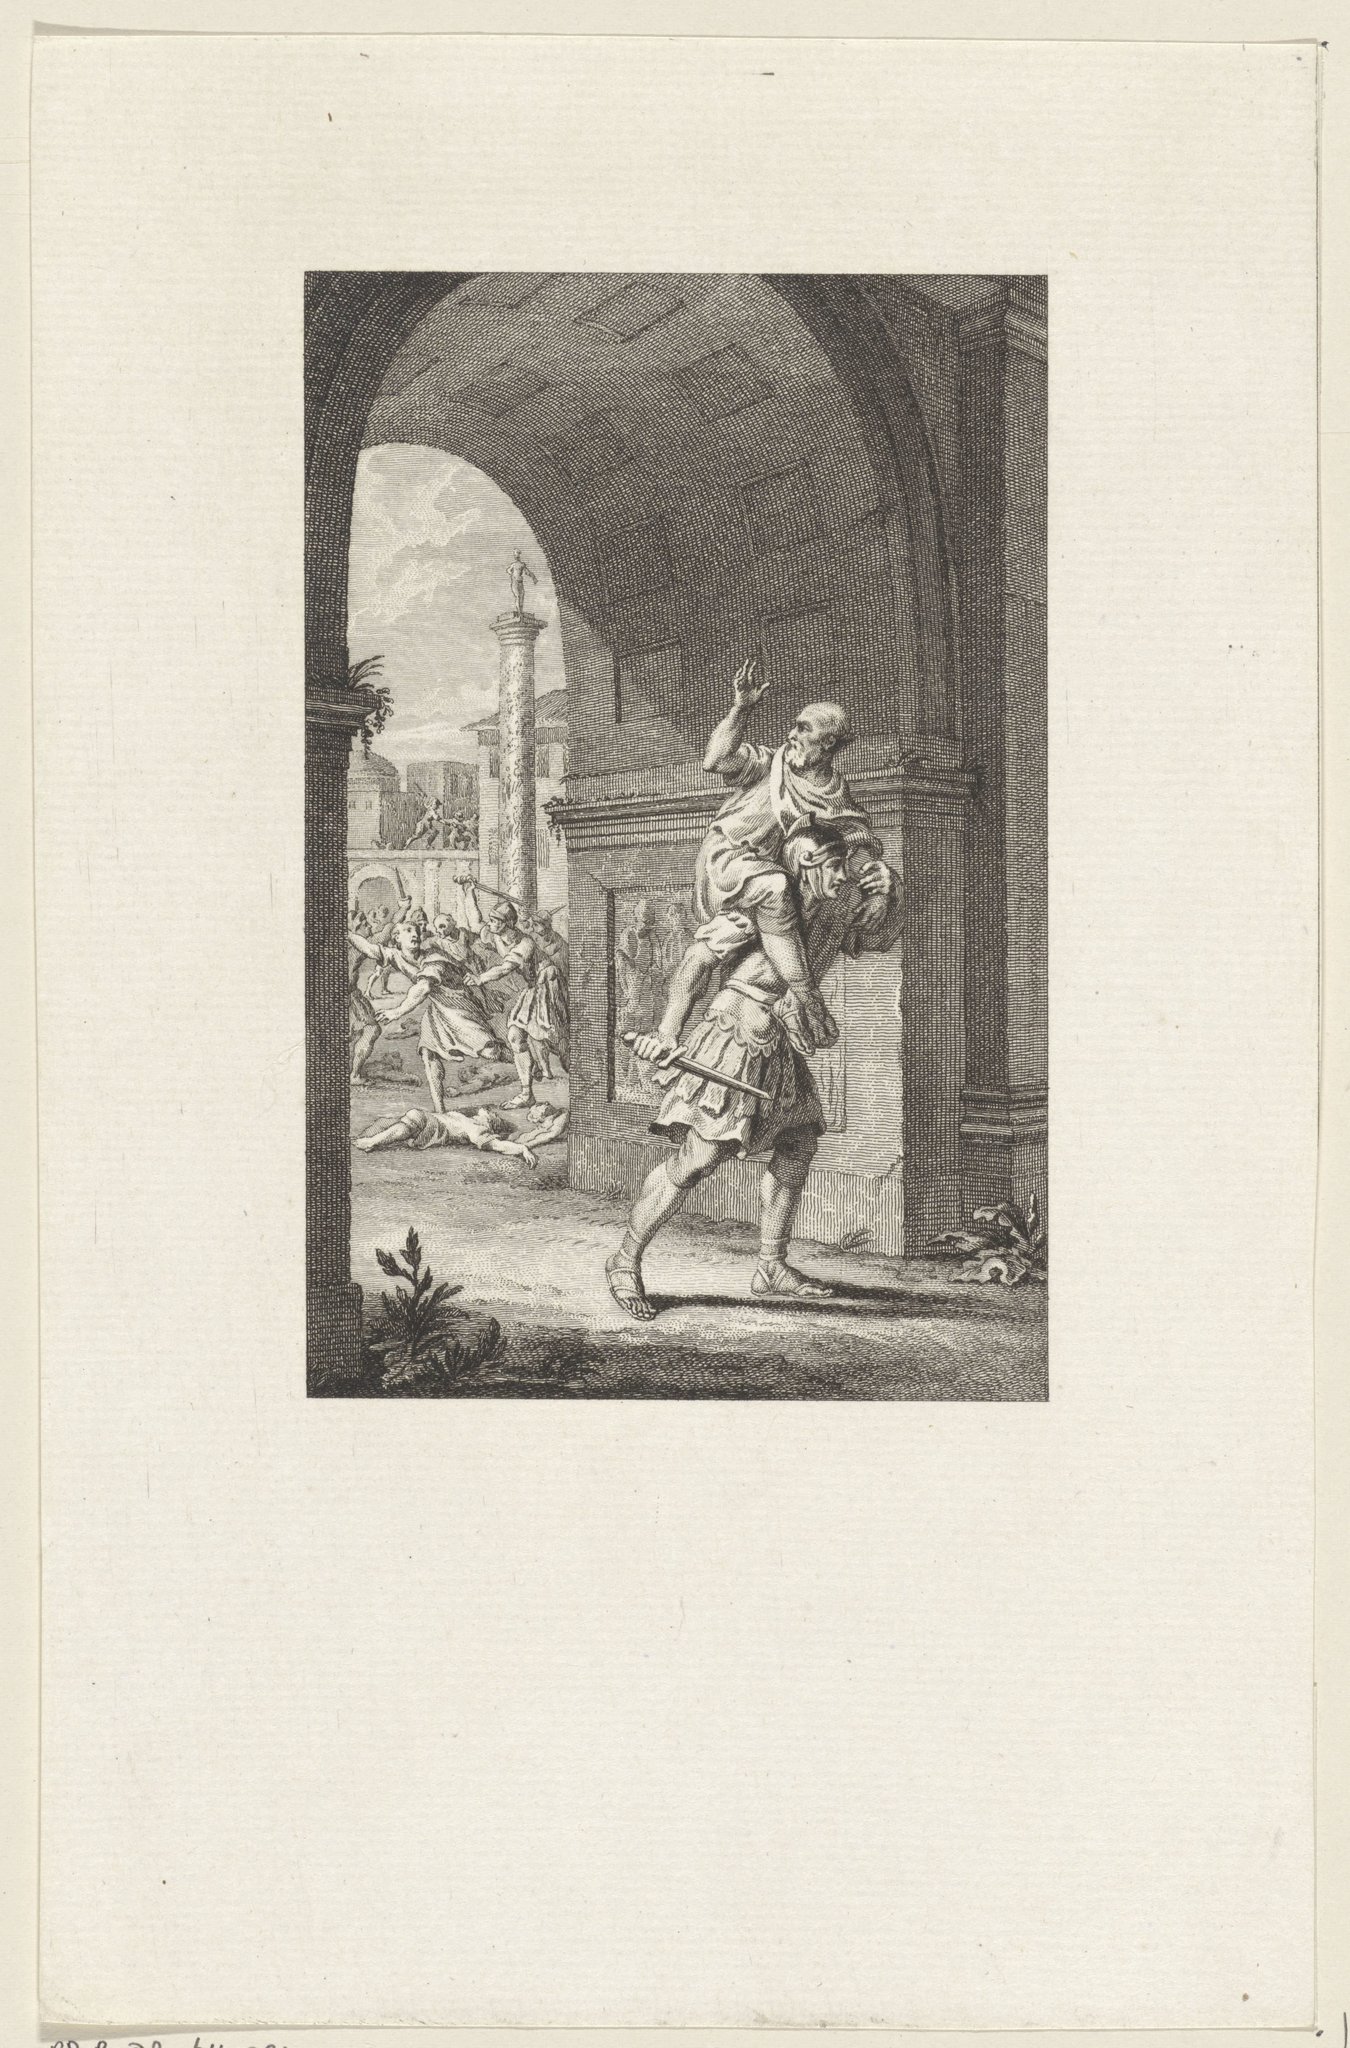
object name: print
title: Oppius wordt door zijn zoon uit Rome gedragen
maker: reinier vinkeles (i)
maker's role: draughtsman, print maker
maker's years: 1741-1816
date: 1781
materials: paper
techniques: engraving, etching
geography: amsterdam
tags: carrying a person on one's back, rome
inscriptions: collector's mark: Lugt 240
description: Prent gebruikt als boekillustratie in: Martinet, Joannes Florentius. Historie der waereld. Amsterdam: Johannes Allart, 1780-1788. 25 delen. deel II, pl. IV.